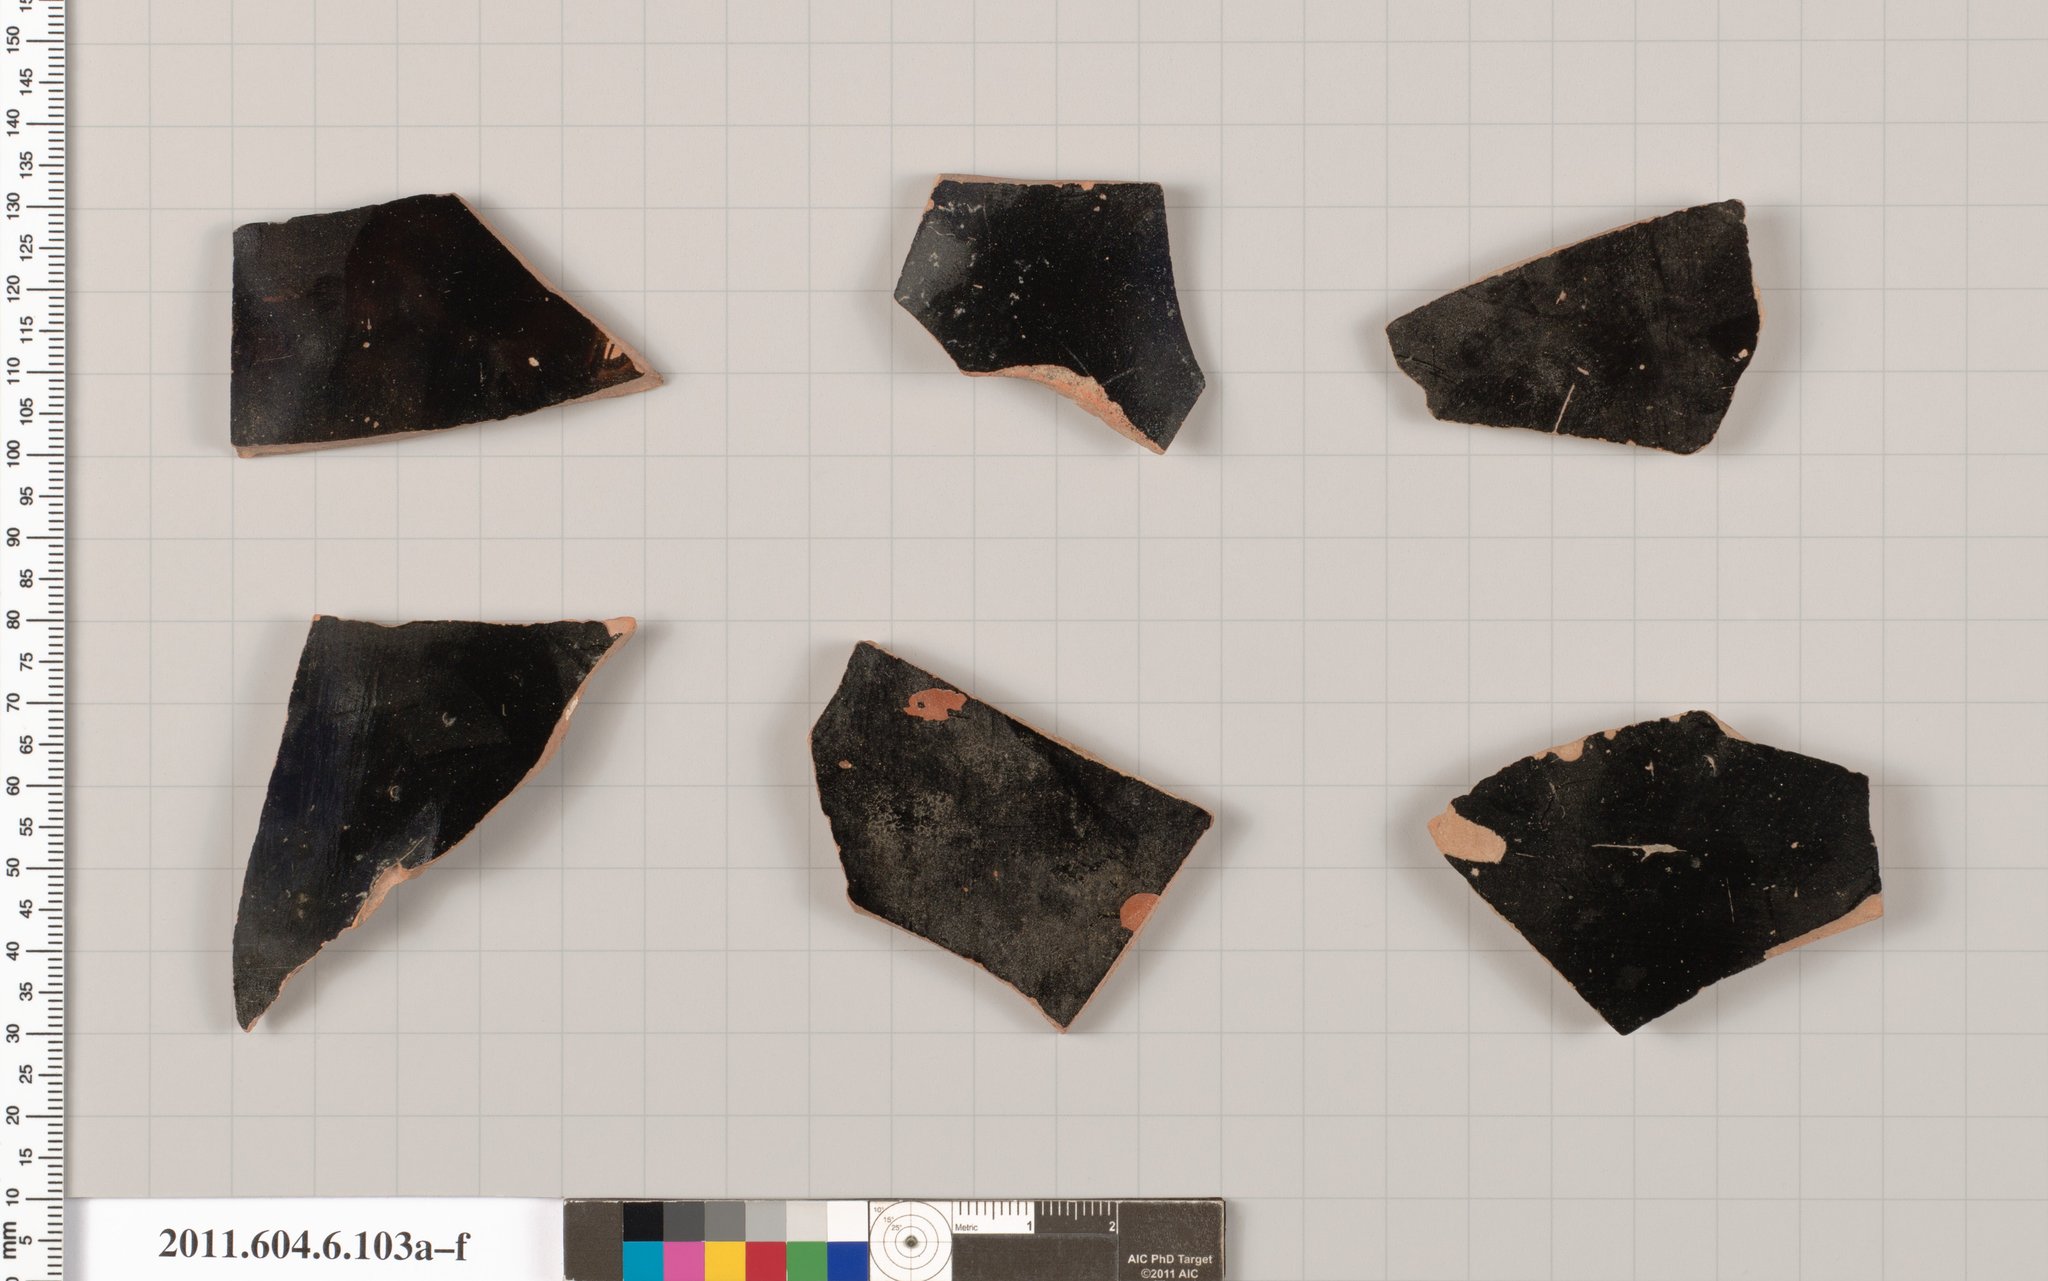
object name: undetermined closed shape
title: Terracotta fragments of closed shapes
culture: greek, attic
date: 600-401 BCE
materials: terracotta